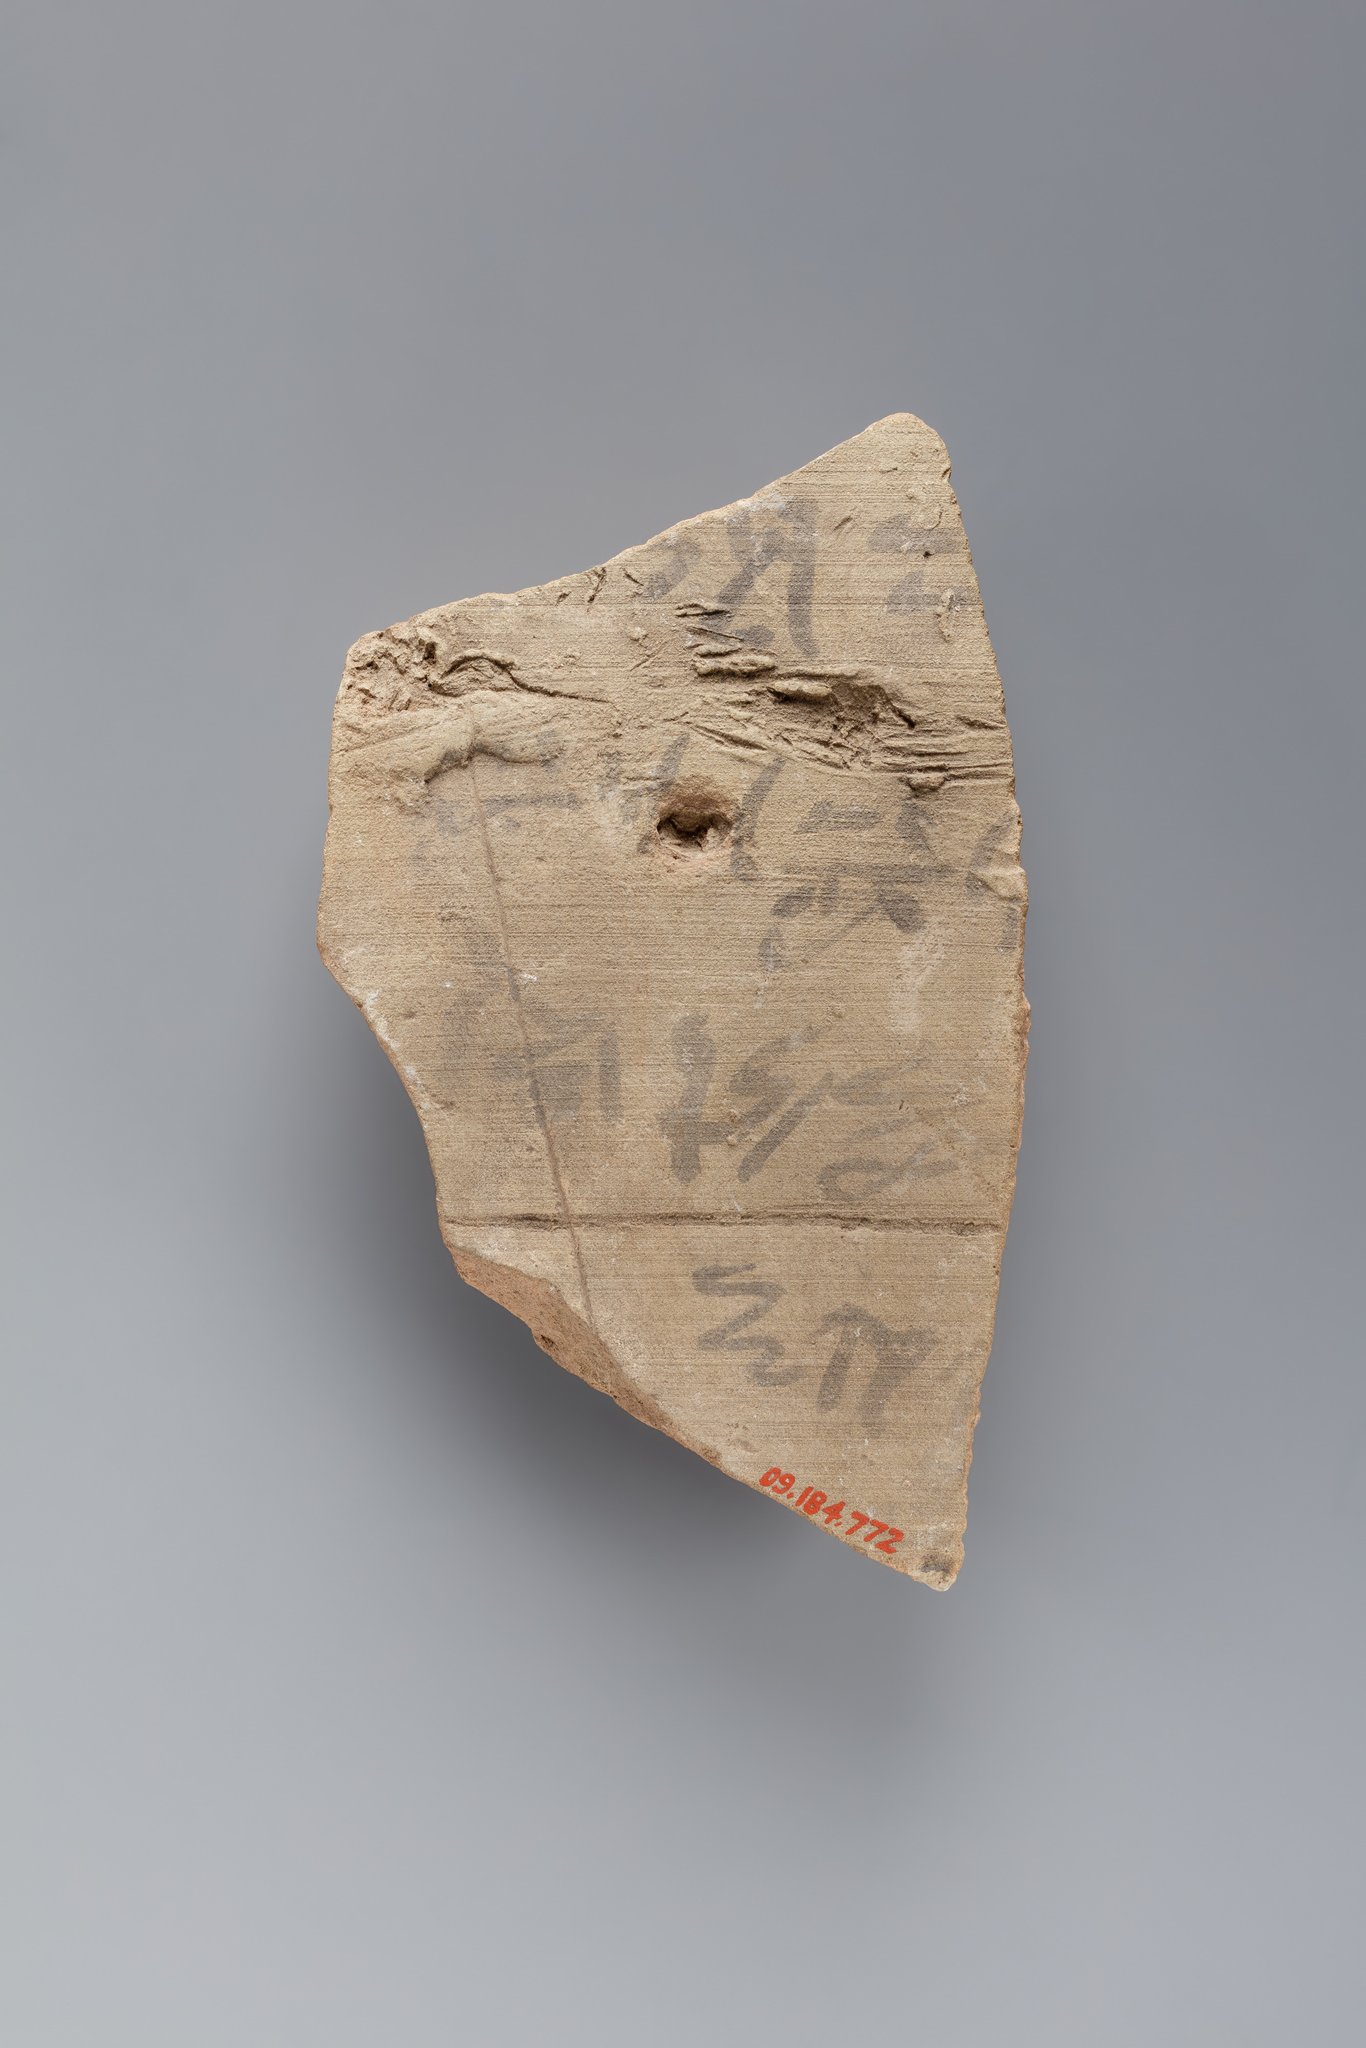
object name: ostracon, hieratic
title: Hieratic ostracon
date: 1295-1070 BCE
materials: ink, paint, pottery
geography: egypt